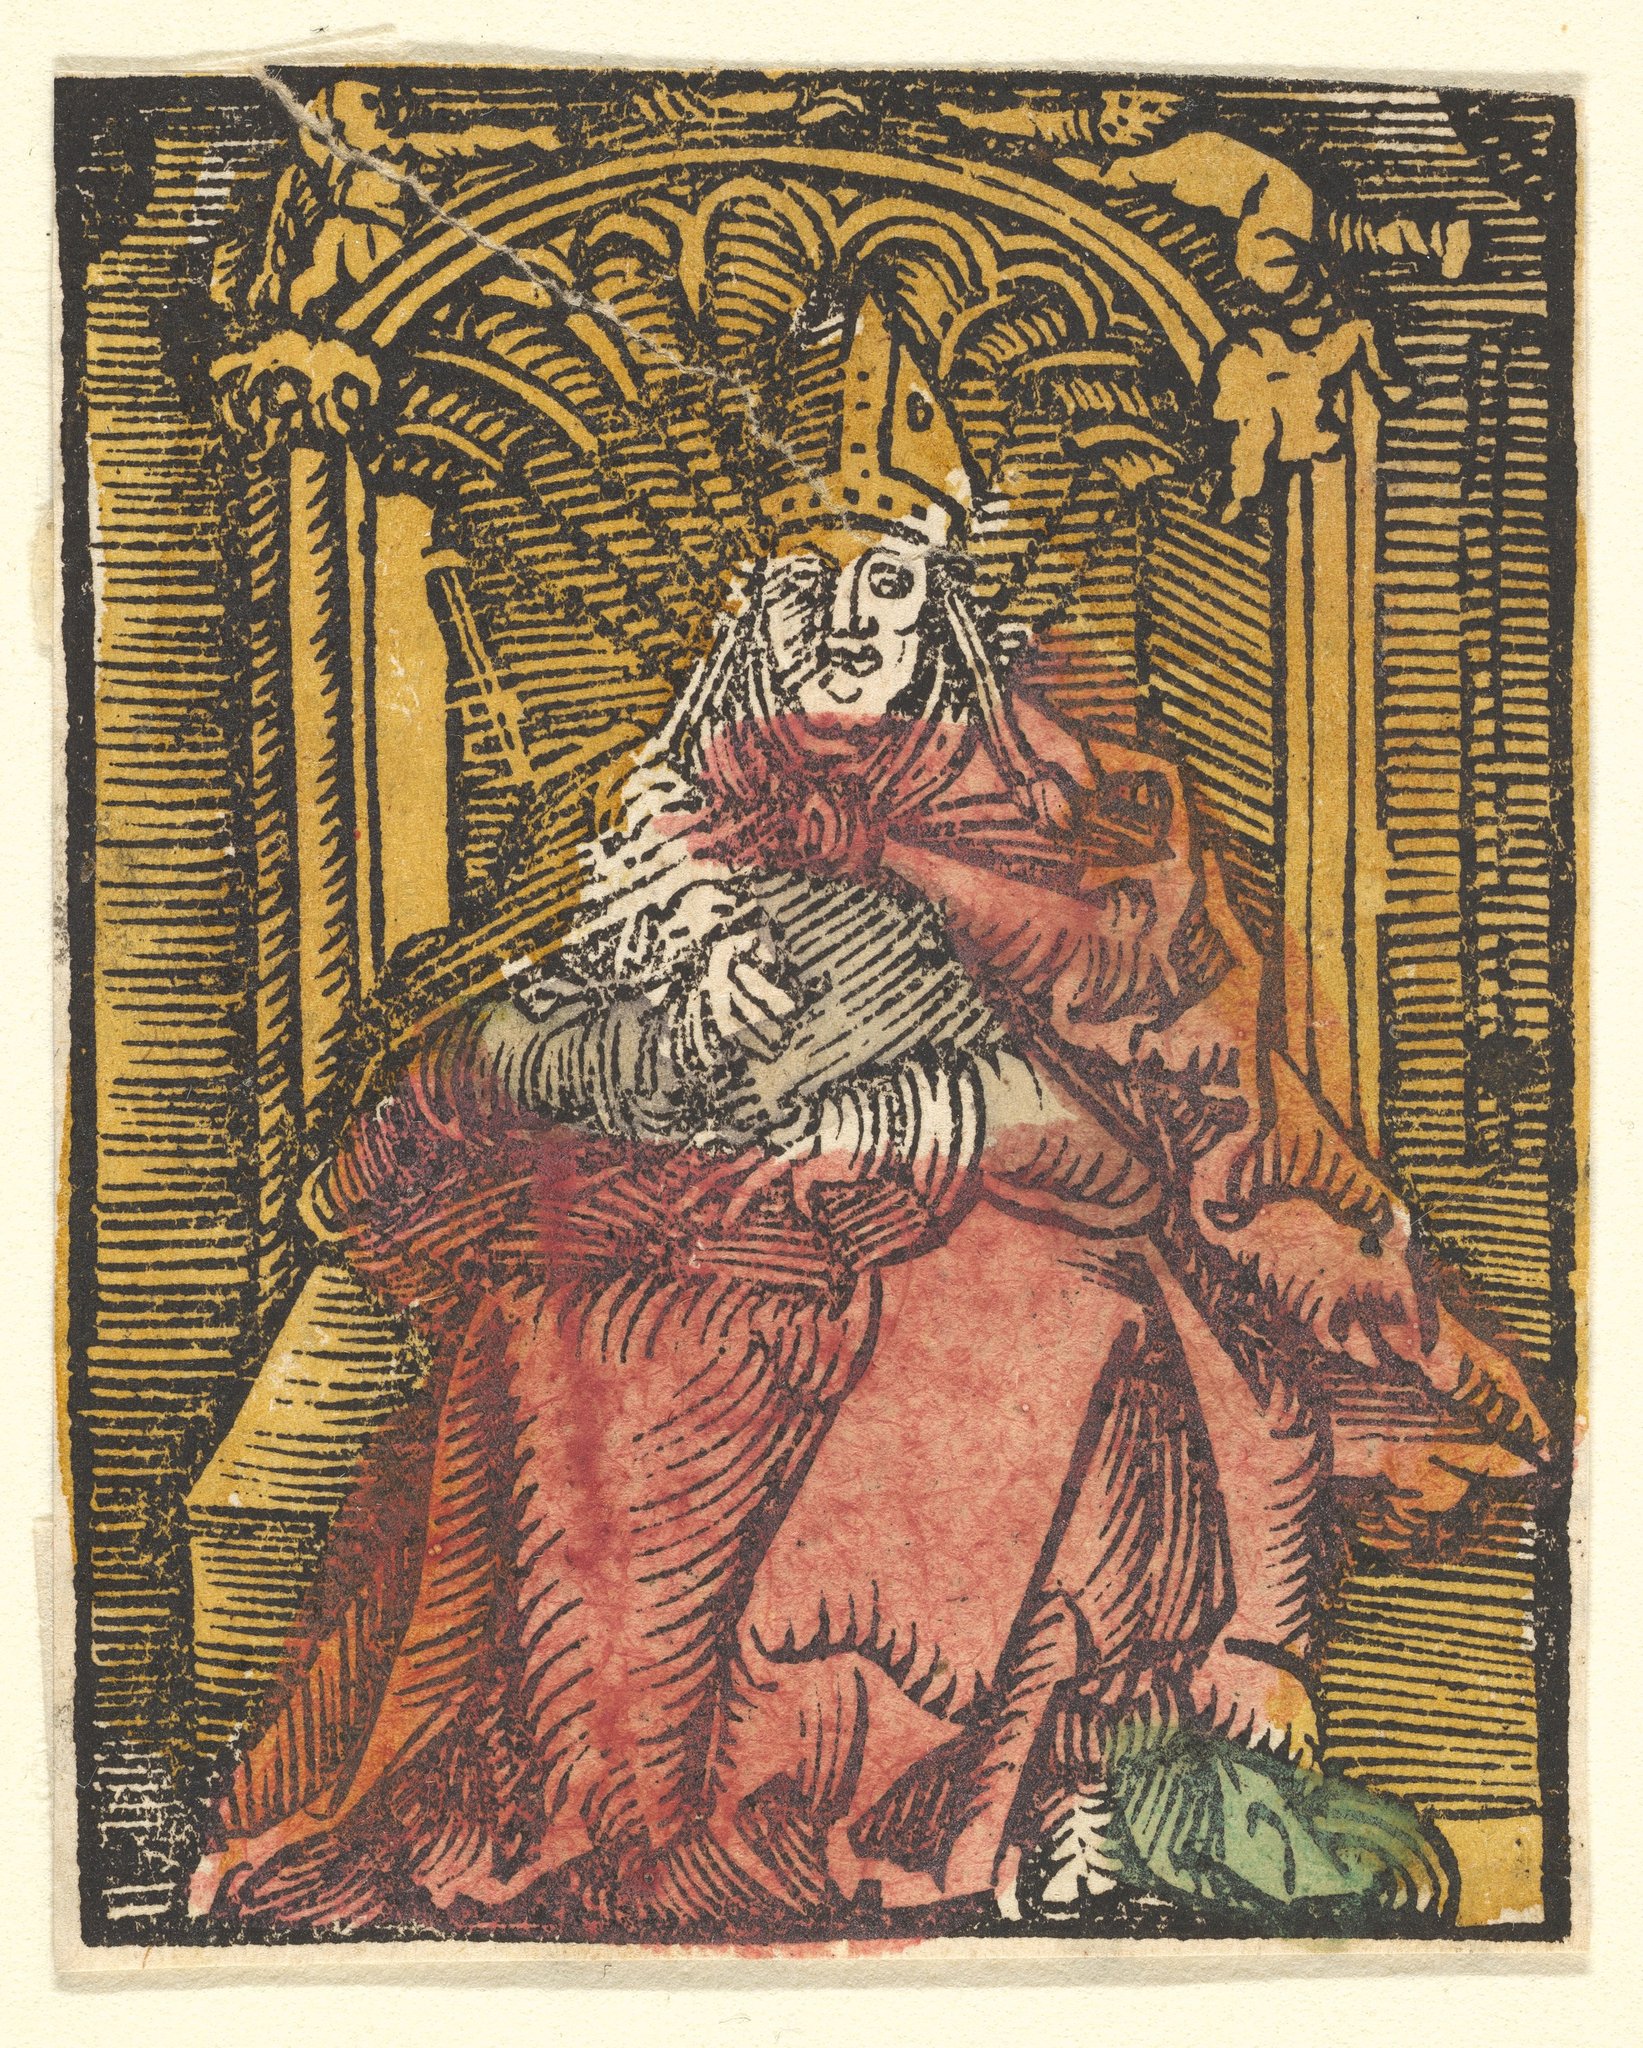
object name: print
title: St. Erasmus (copy)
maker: hans baldung (called hans baldung grien)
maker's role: artist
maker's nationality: german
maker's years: 1484-1545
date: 1512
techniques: hand coloring, woodcut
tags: men,saints